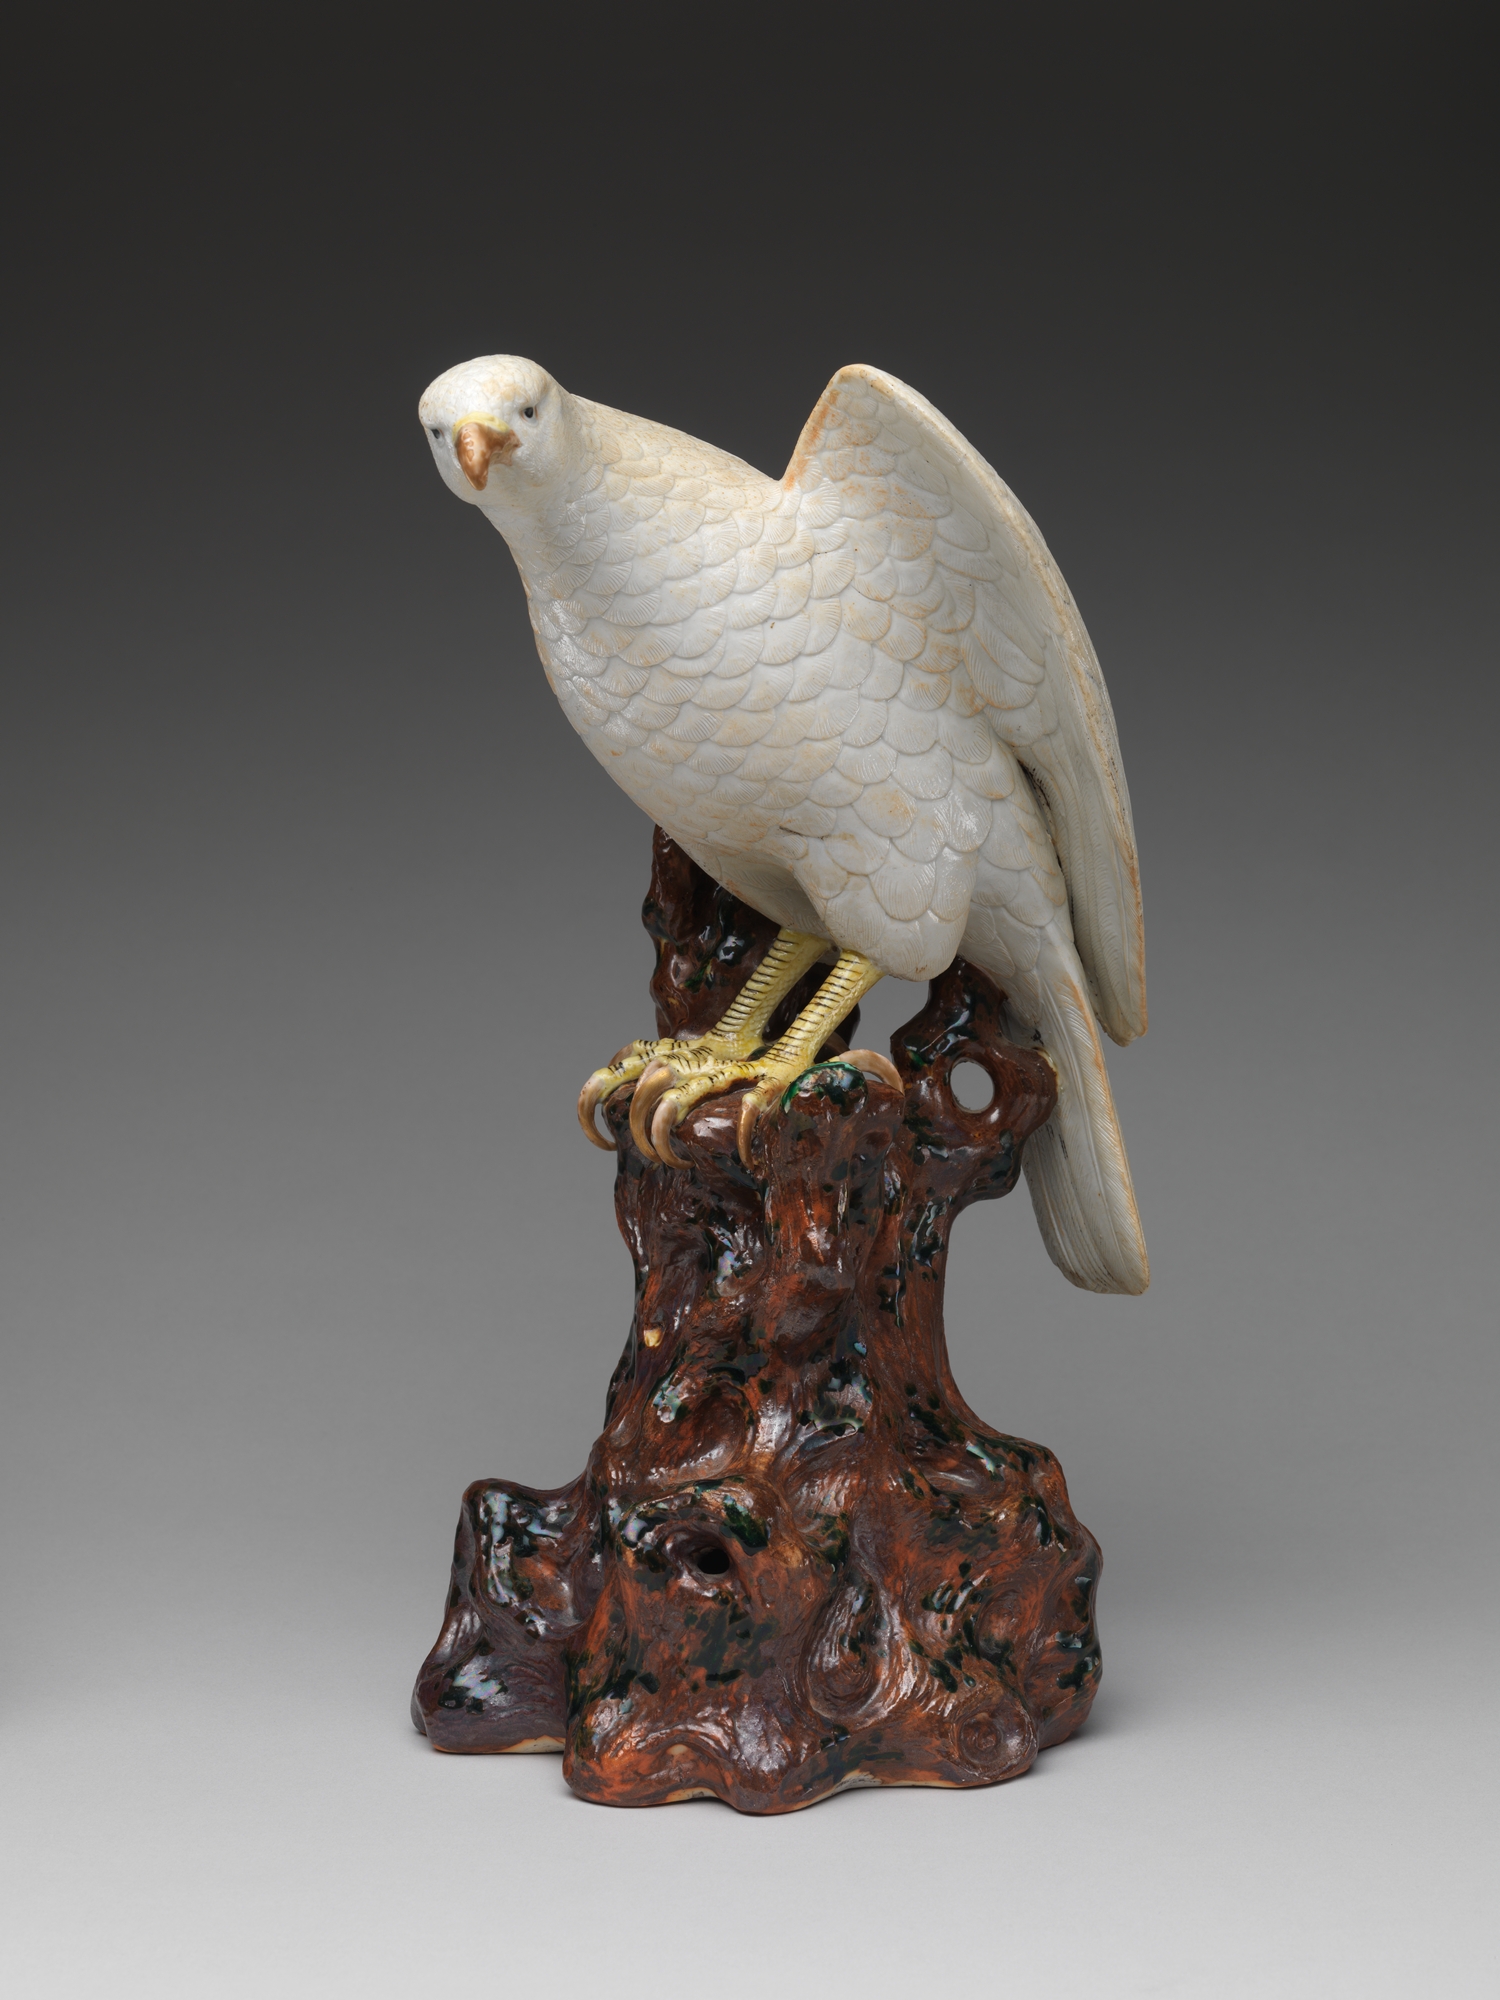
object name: figure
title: Hawk on a Tree Stump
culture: japanese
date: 1820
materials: enamel, porcelain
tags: hawks